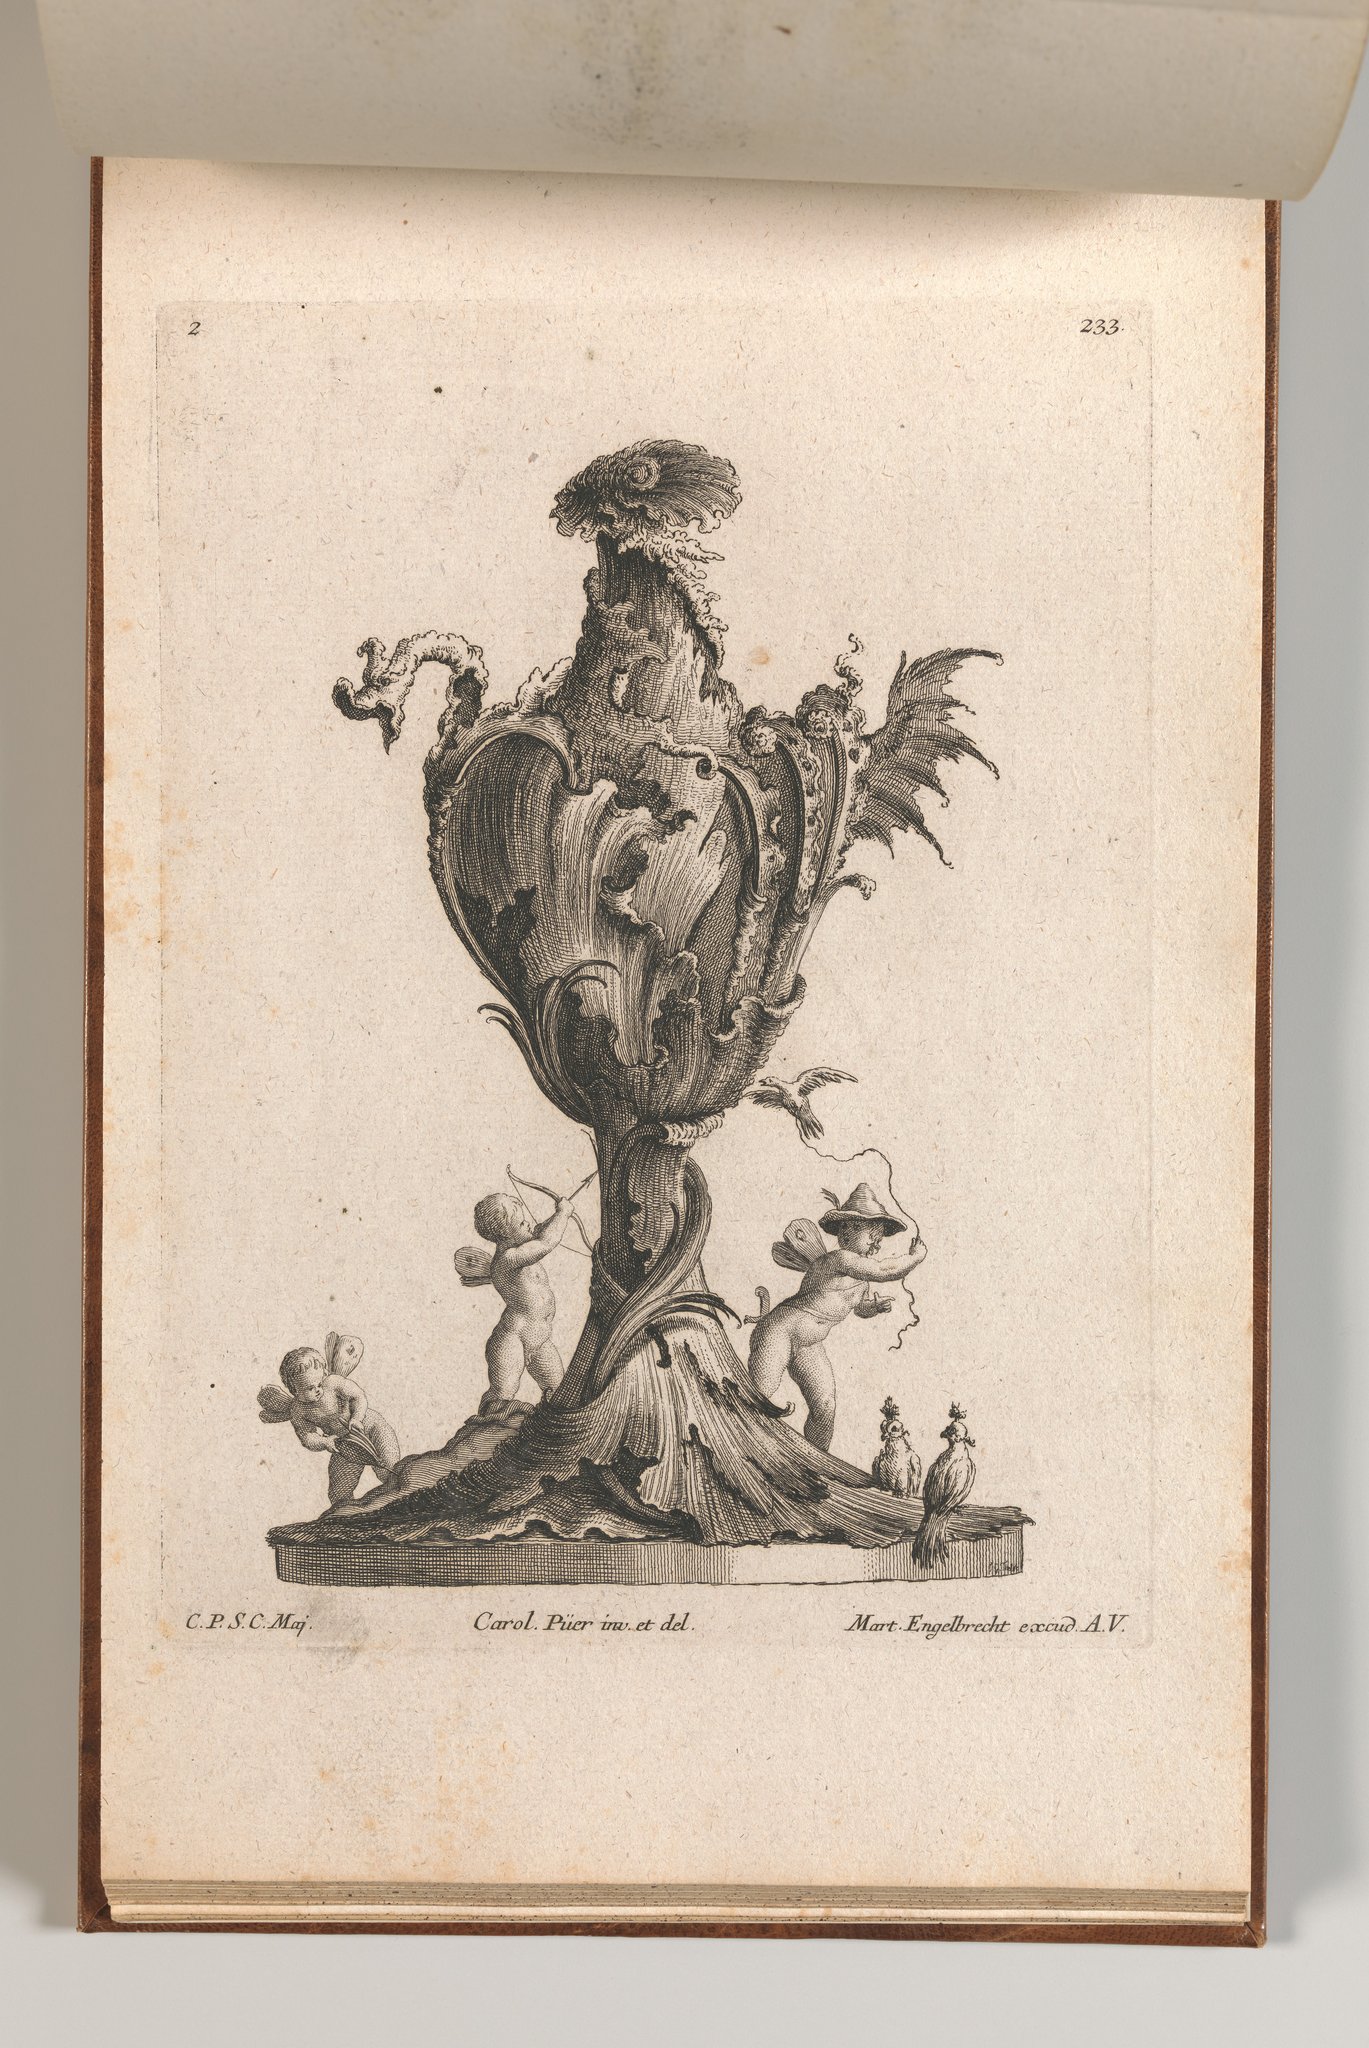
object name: album print ornament architecture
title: Design for a large Vase or Ewer representing 'Air', Plate 2 from: 'Neu inventierte Vasi auf die neueste manier'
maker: jacob gottlieb thelot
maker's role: engraver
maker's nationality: central european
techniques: etching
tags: falcons,ornament,putti,vases